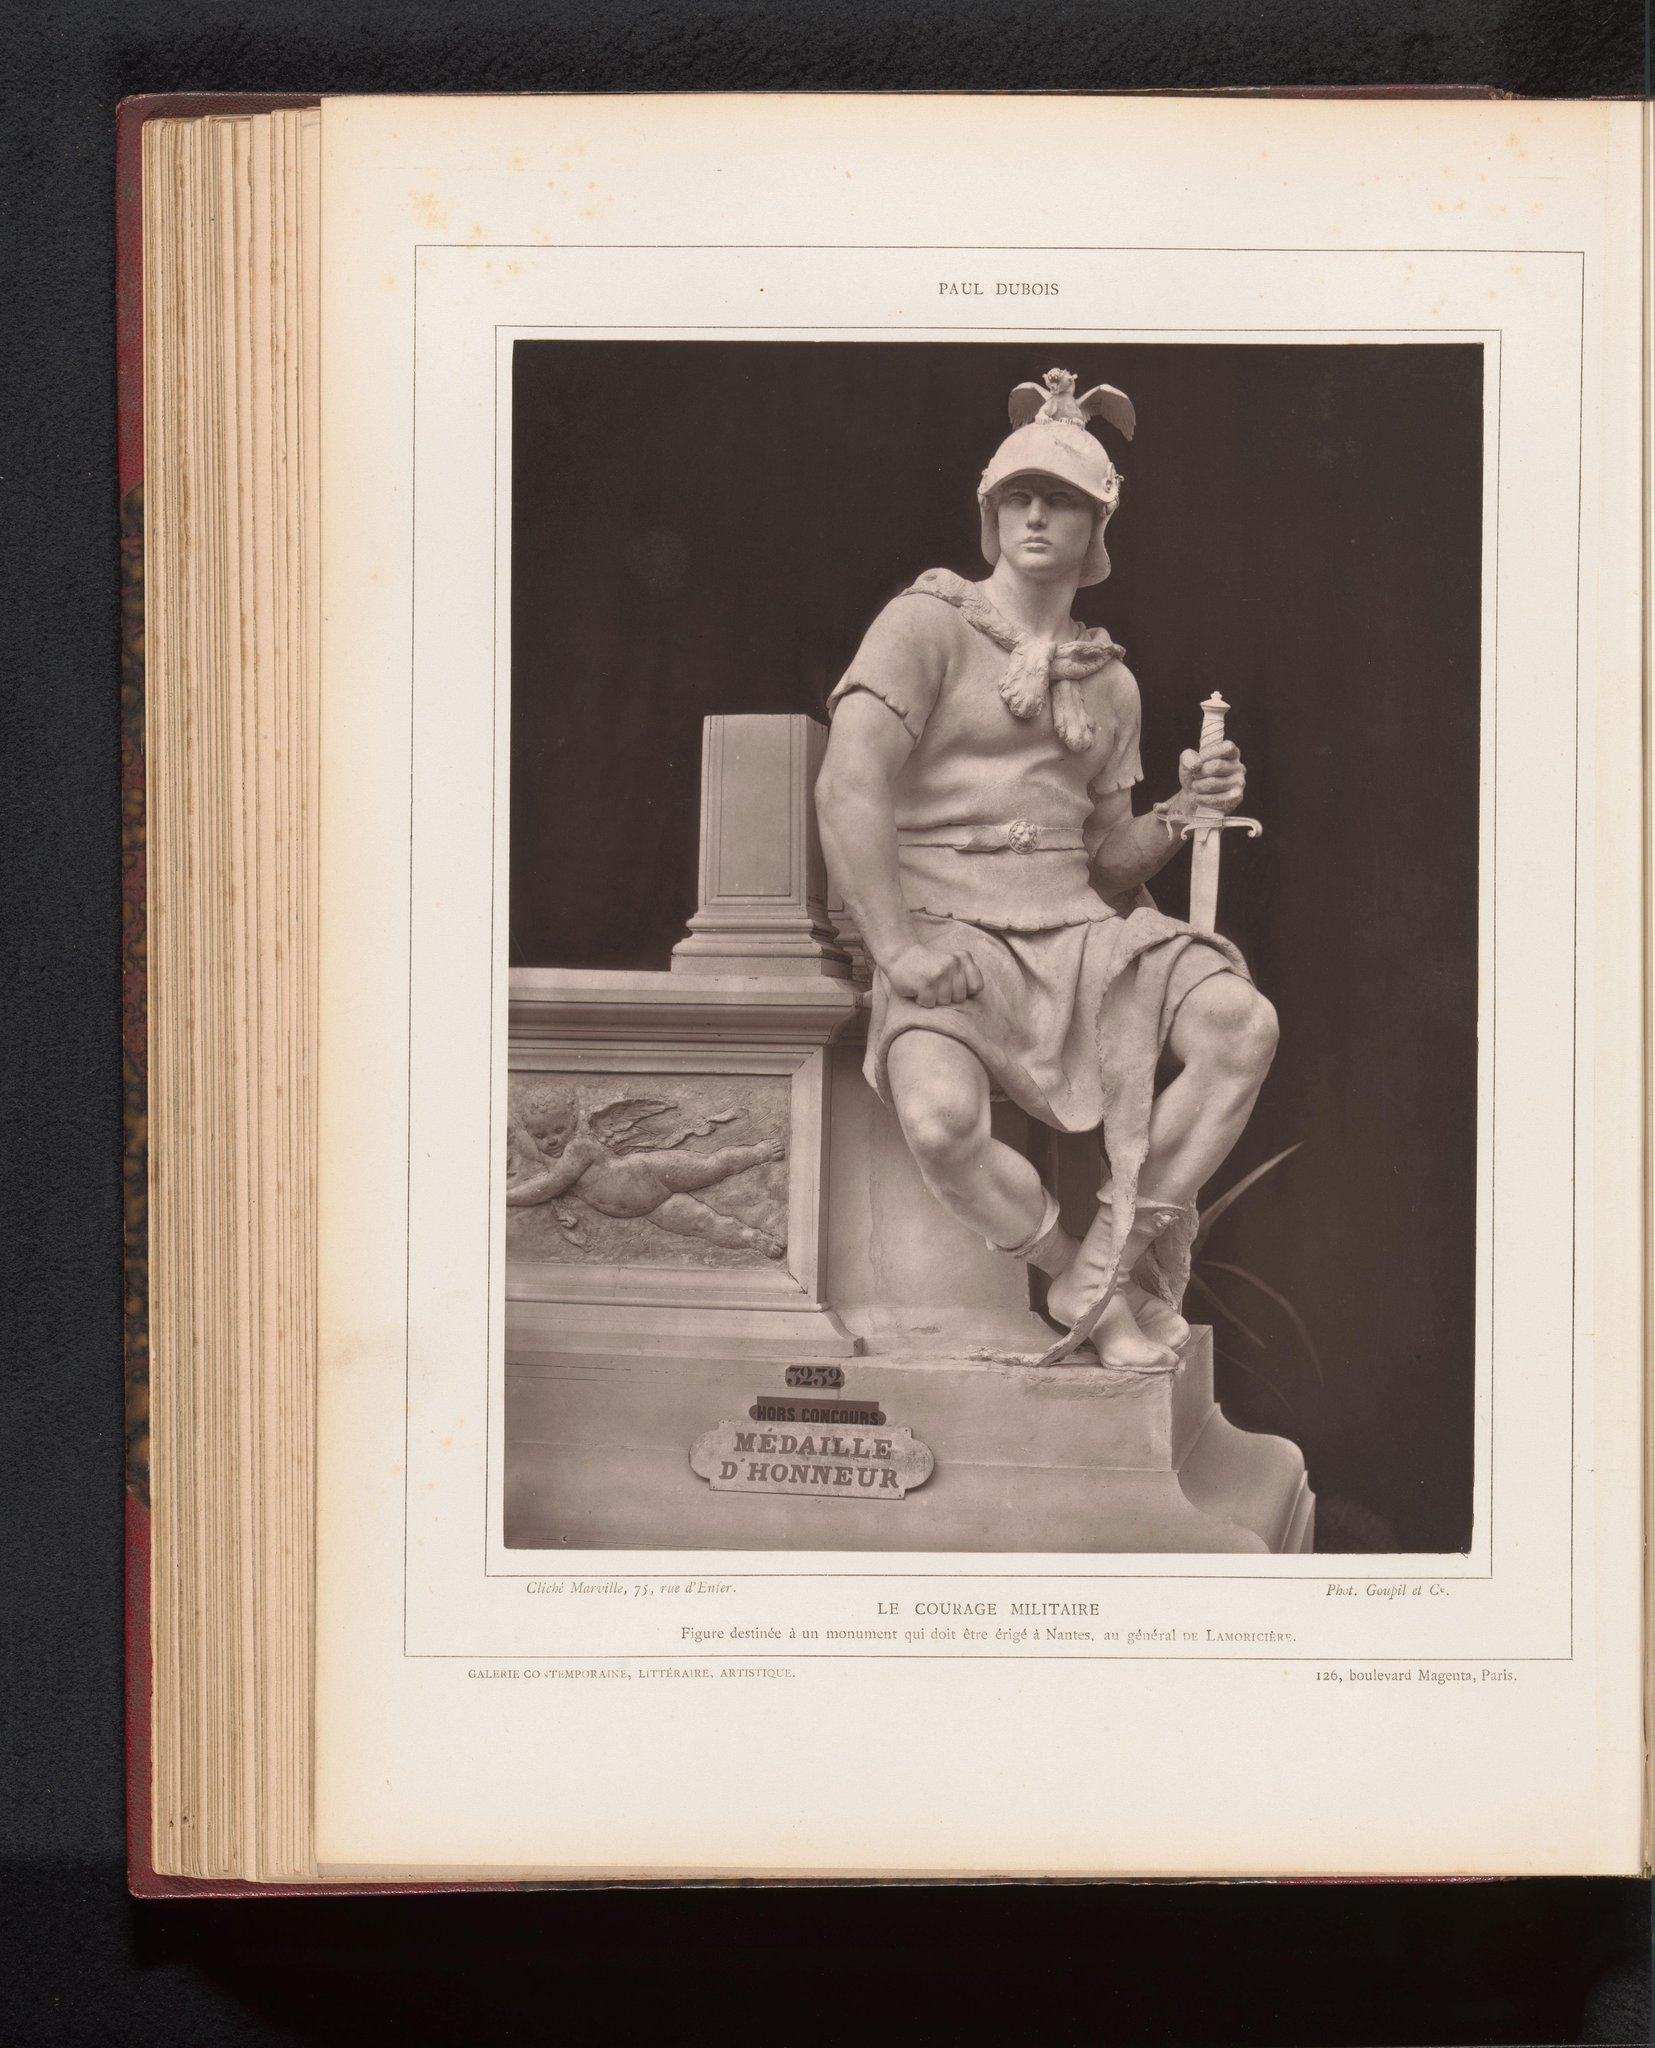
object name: page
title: Le courage militaire - Figure destinée a un monument qui doit être érigé a Nantes, au général de Lamoriciere.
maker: charles marville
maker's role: print maker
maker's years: 1816-1879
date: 1872-1877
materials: paper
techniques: woodburytype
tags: the soldier; the soldier's life, sculpture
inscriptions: inscription: ‘Paul Dubois/ Galerie Contemporaine, Littéraire, Artistique/ 126, boulevard de Magenta, Paris.’